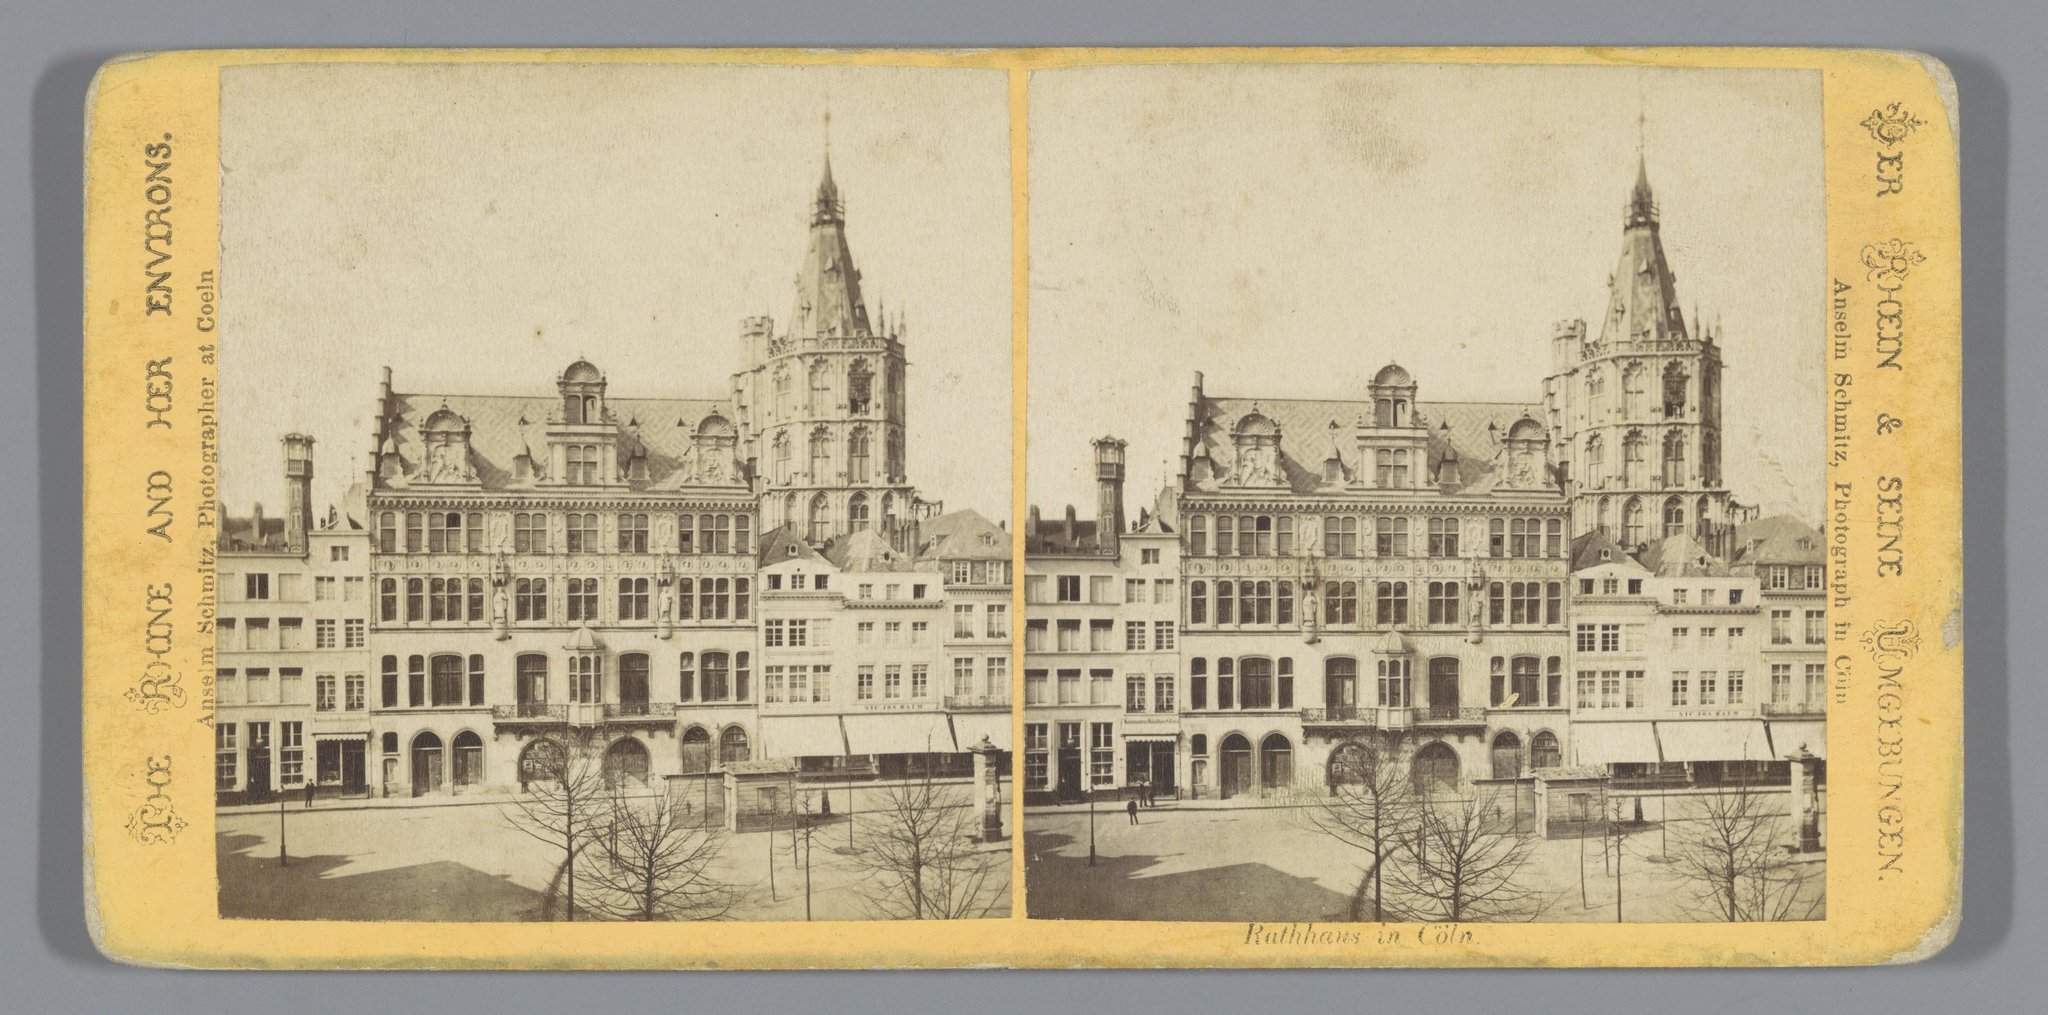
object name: stereograph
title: Rathhaus in Coln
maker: anselm schmitz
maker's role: publisher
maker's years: 1831-1903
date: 1860-1870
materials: cardboard, photographic support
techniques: albumen print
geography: cologne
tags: townhall, façade (of house or building)